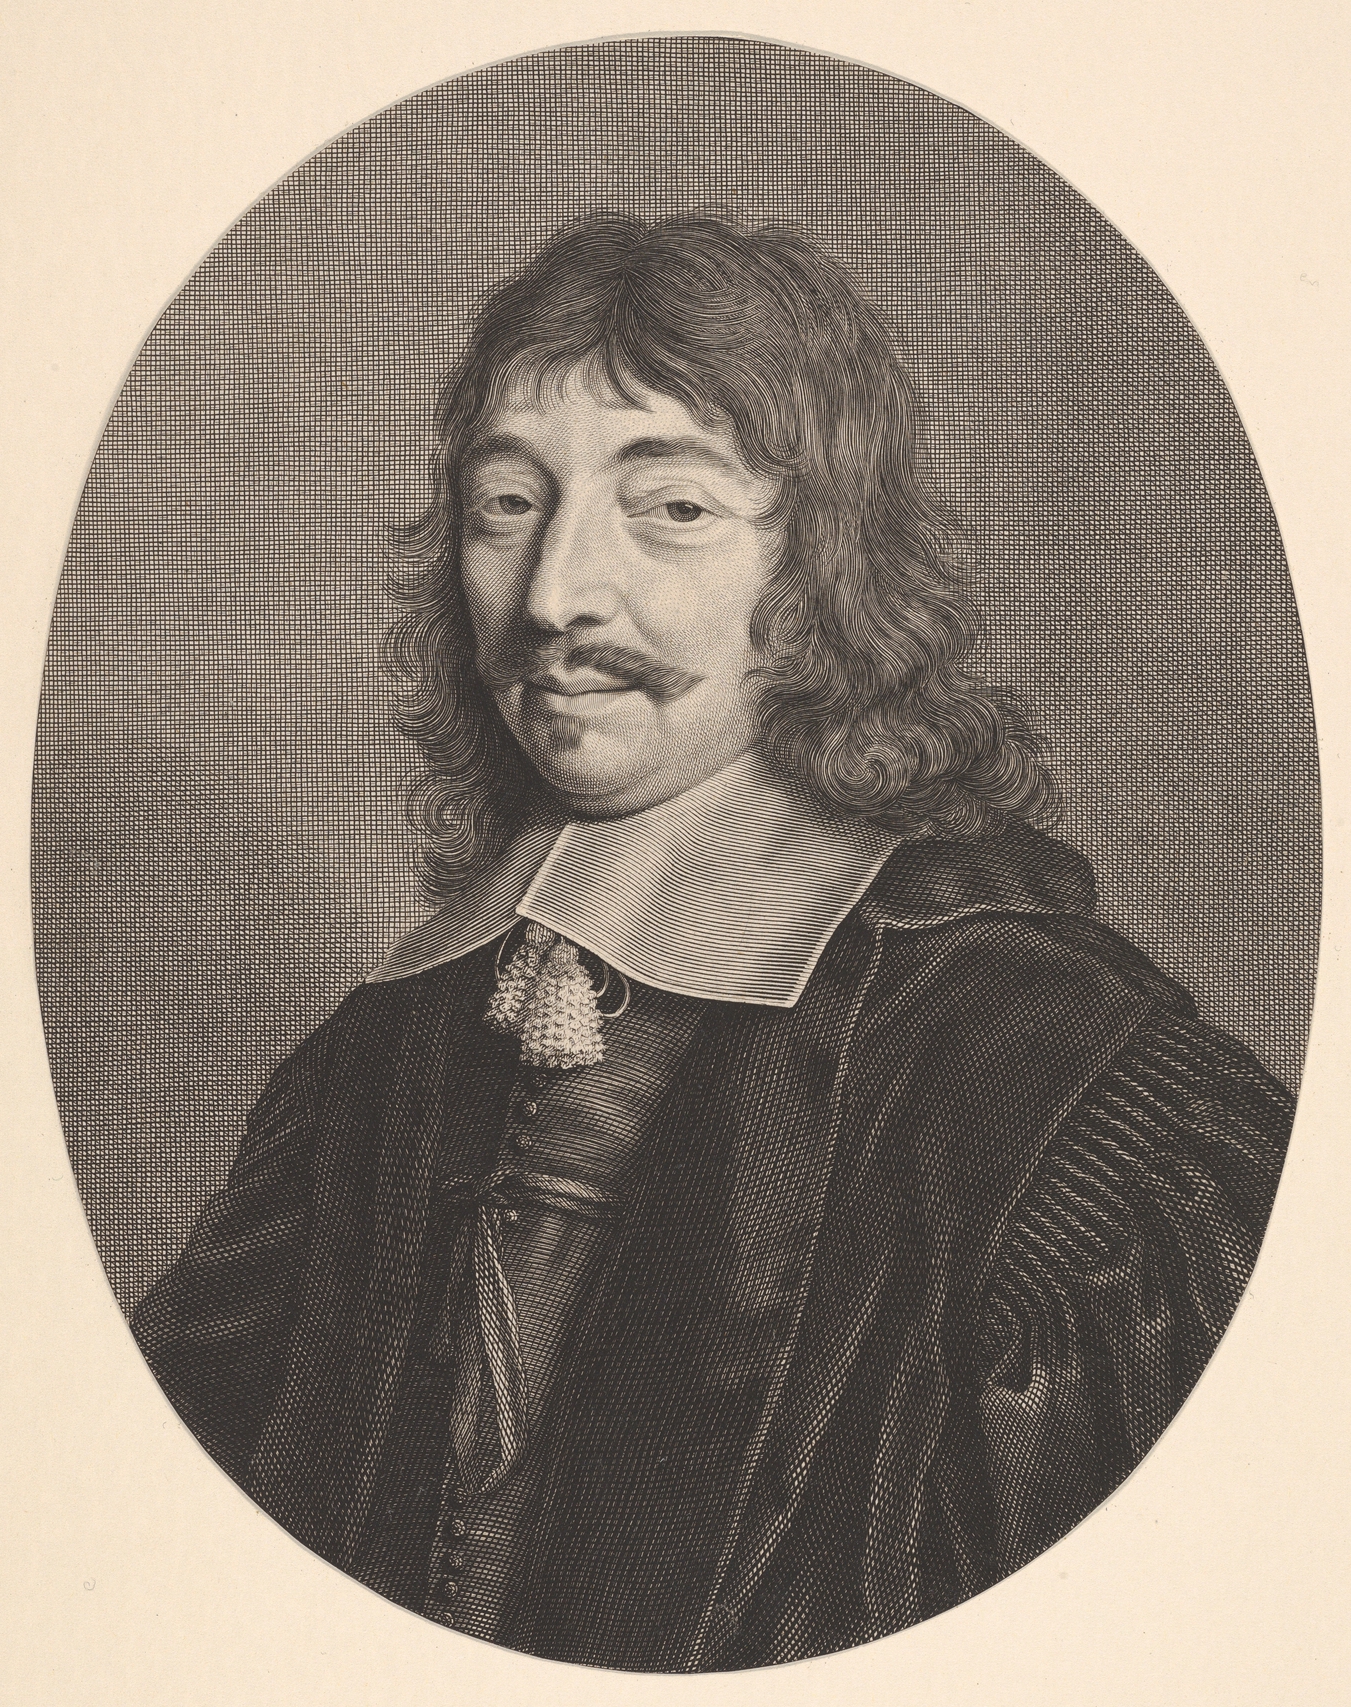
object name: print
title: Jacques Amelot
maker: robert nanteuil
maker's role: artist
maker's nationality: french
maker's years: 1623-1678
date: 1655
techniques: engraving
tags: men,portraits